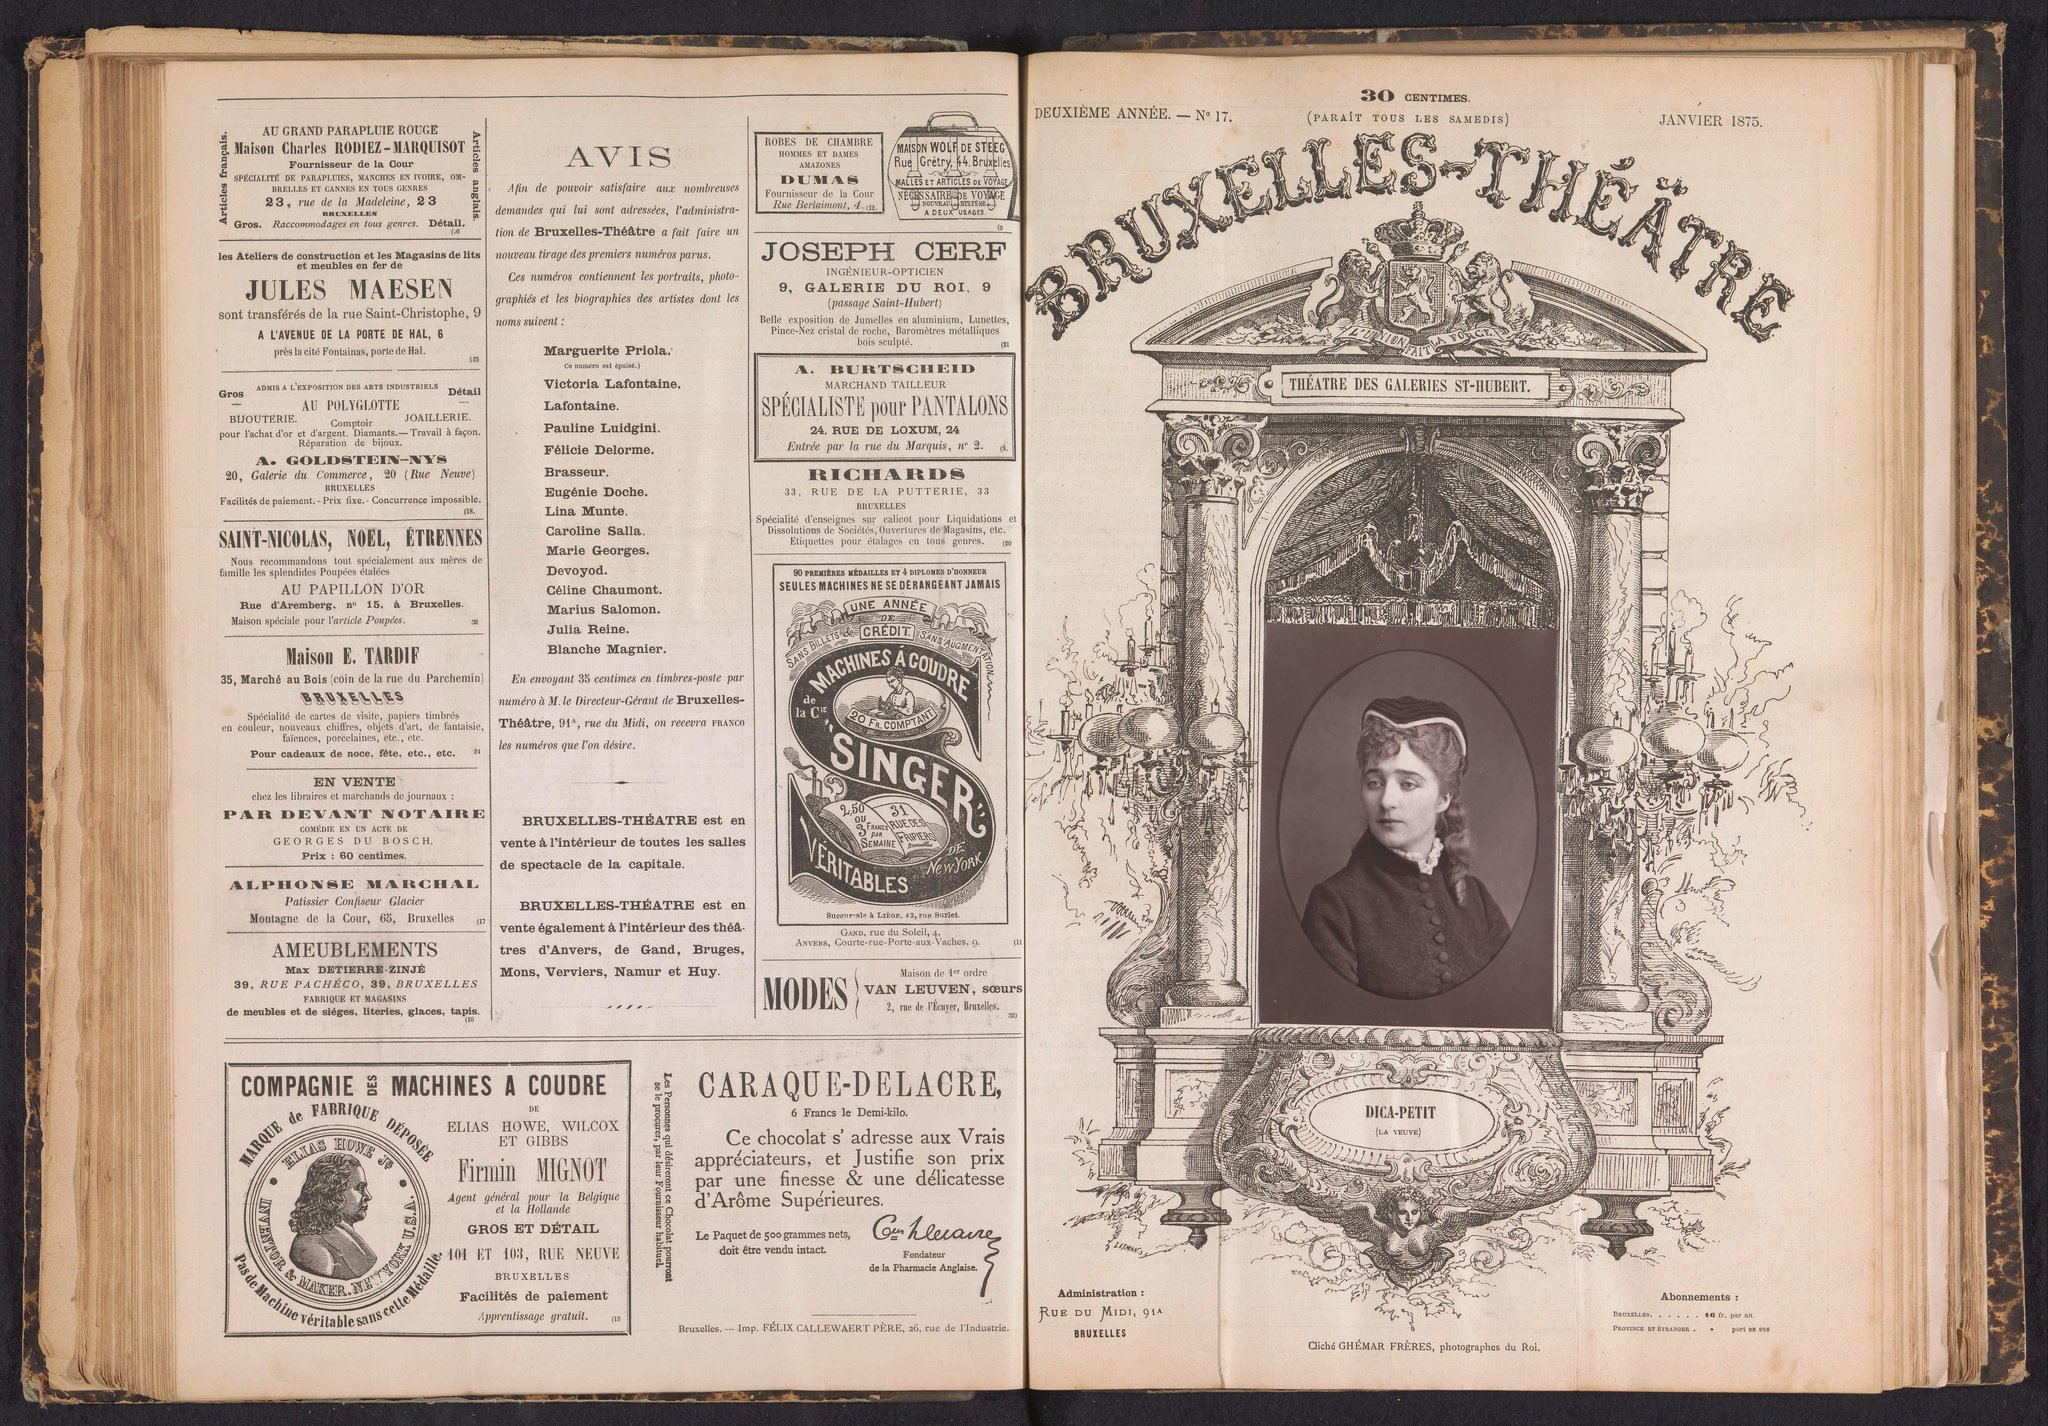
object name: page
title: Portret van mademoiselle Dica-Petit in La veuve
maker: Anonymous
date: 1869-1874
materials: paper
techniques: woodburytype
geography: brussels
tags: portrait of opera-singer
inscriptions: number: ‘No 17.’